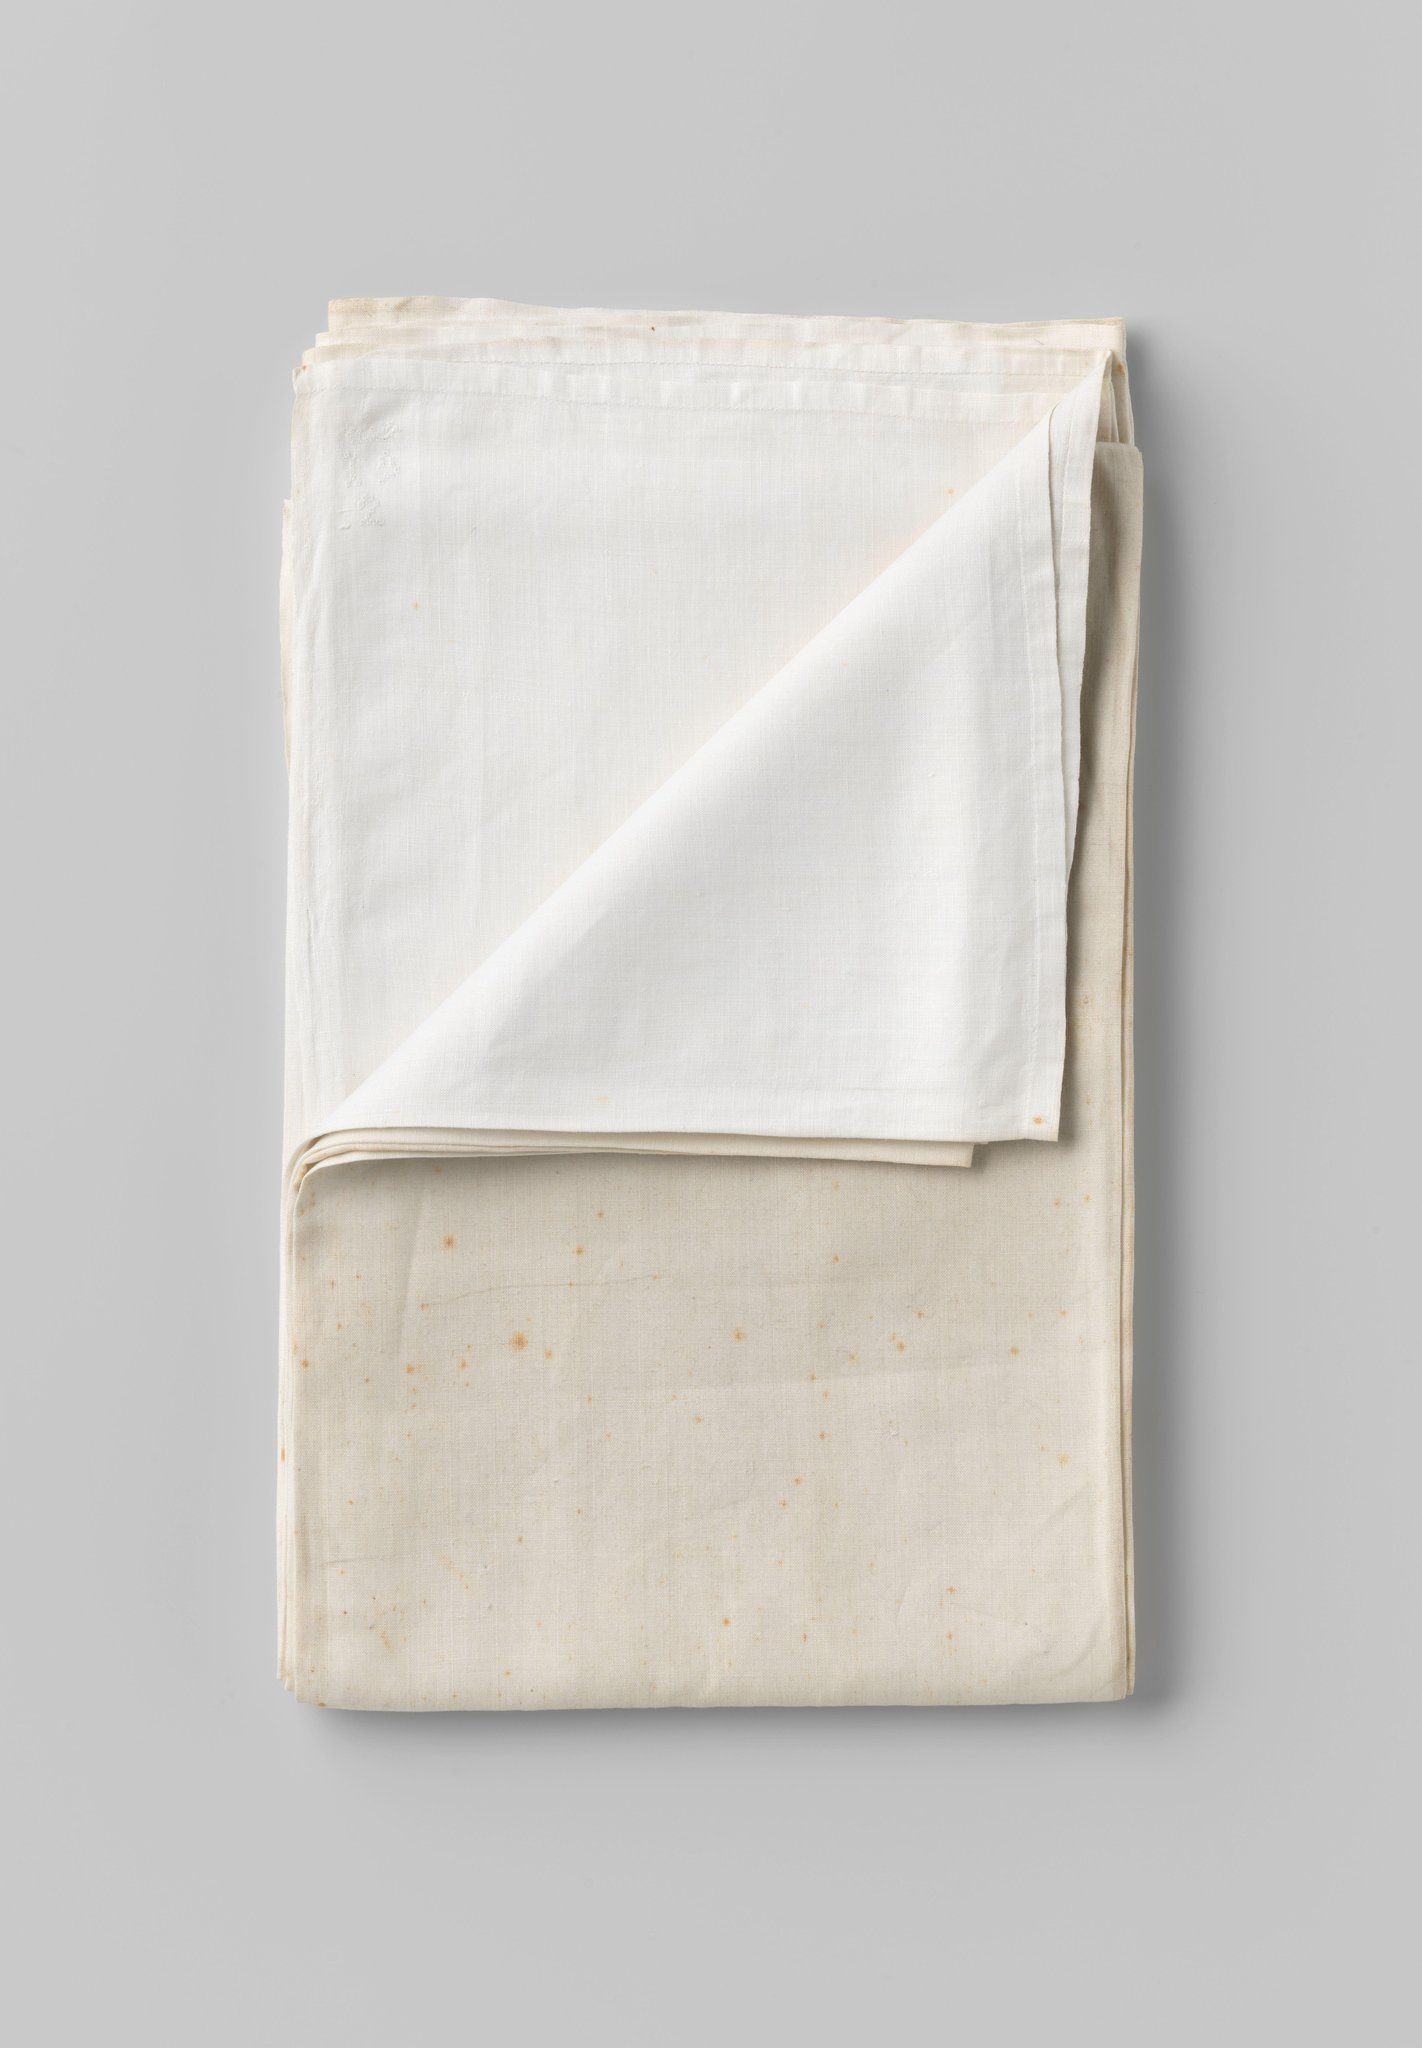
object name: beddenlaken, laken object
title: Laken. Merk: IG 2 en HW 12.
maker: Anonymous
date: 1700-1770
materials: linen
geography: northern netherlands